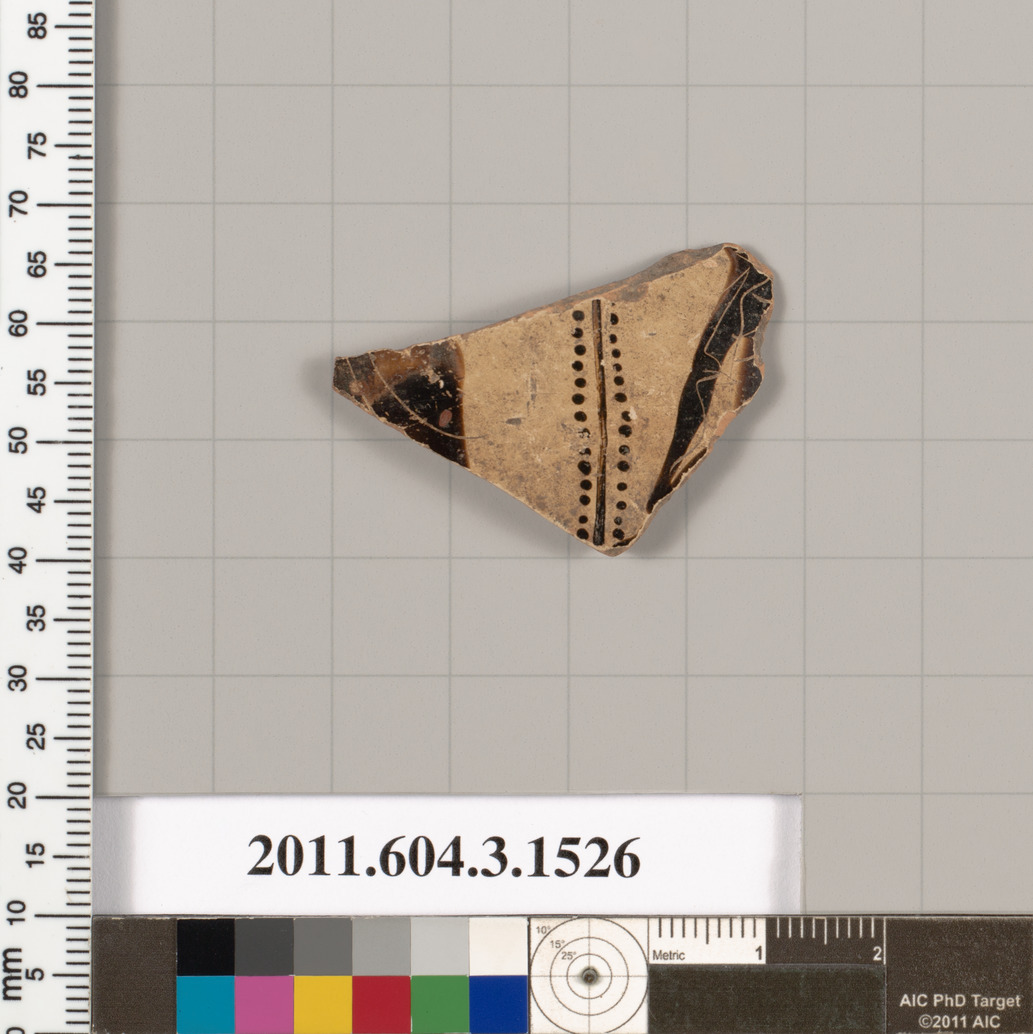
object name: skyphos fragment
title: Terracotta fragment of a skyphos (deep drinking cup)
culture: greek, attic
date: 534-468 BCE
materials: terracotta